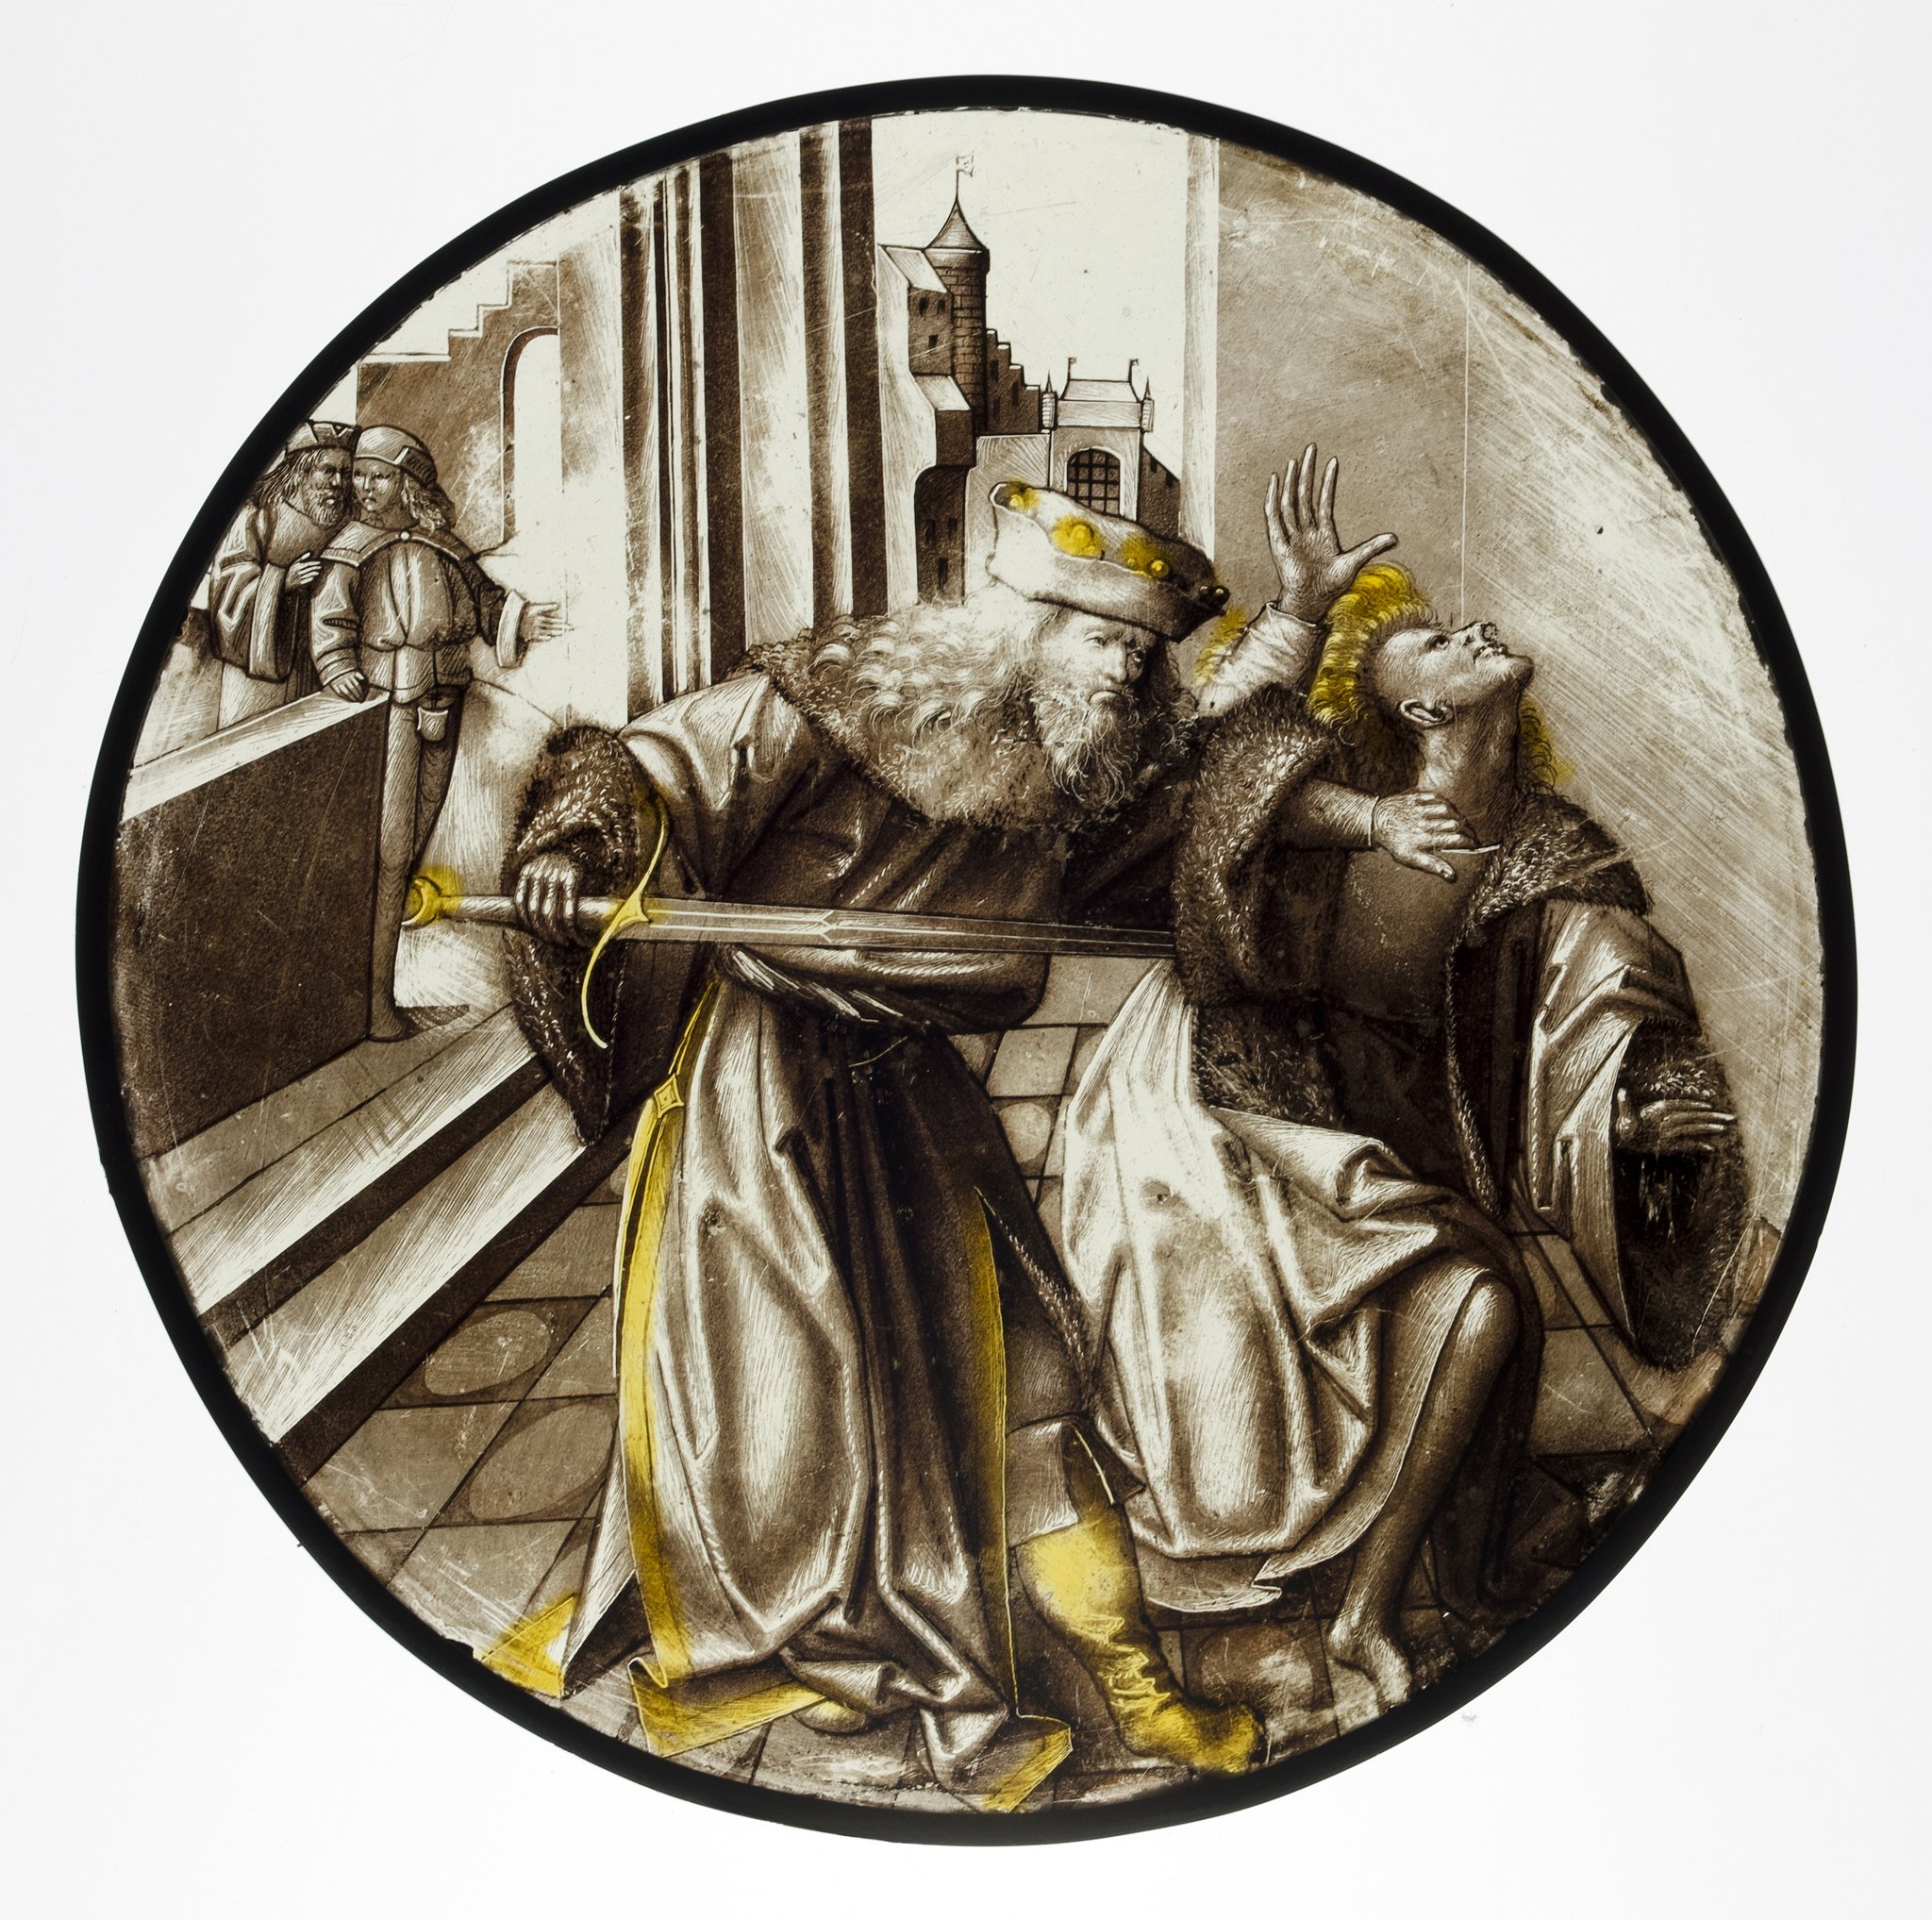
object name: roundel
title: Roundel with Joab Murdering Abner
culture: dutch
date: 1510-1520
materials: glass, paint, pigment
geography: netherlands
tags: swords,suffering